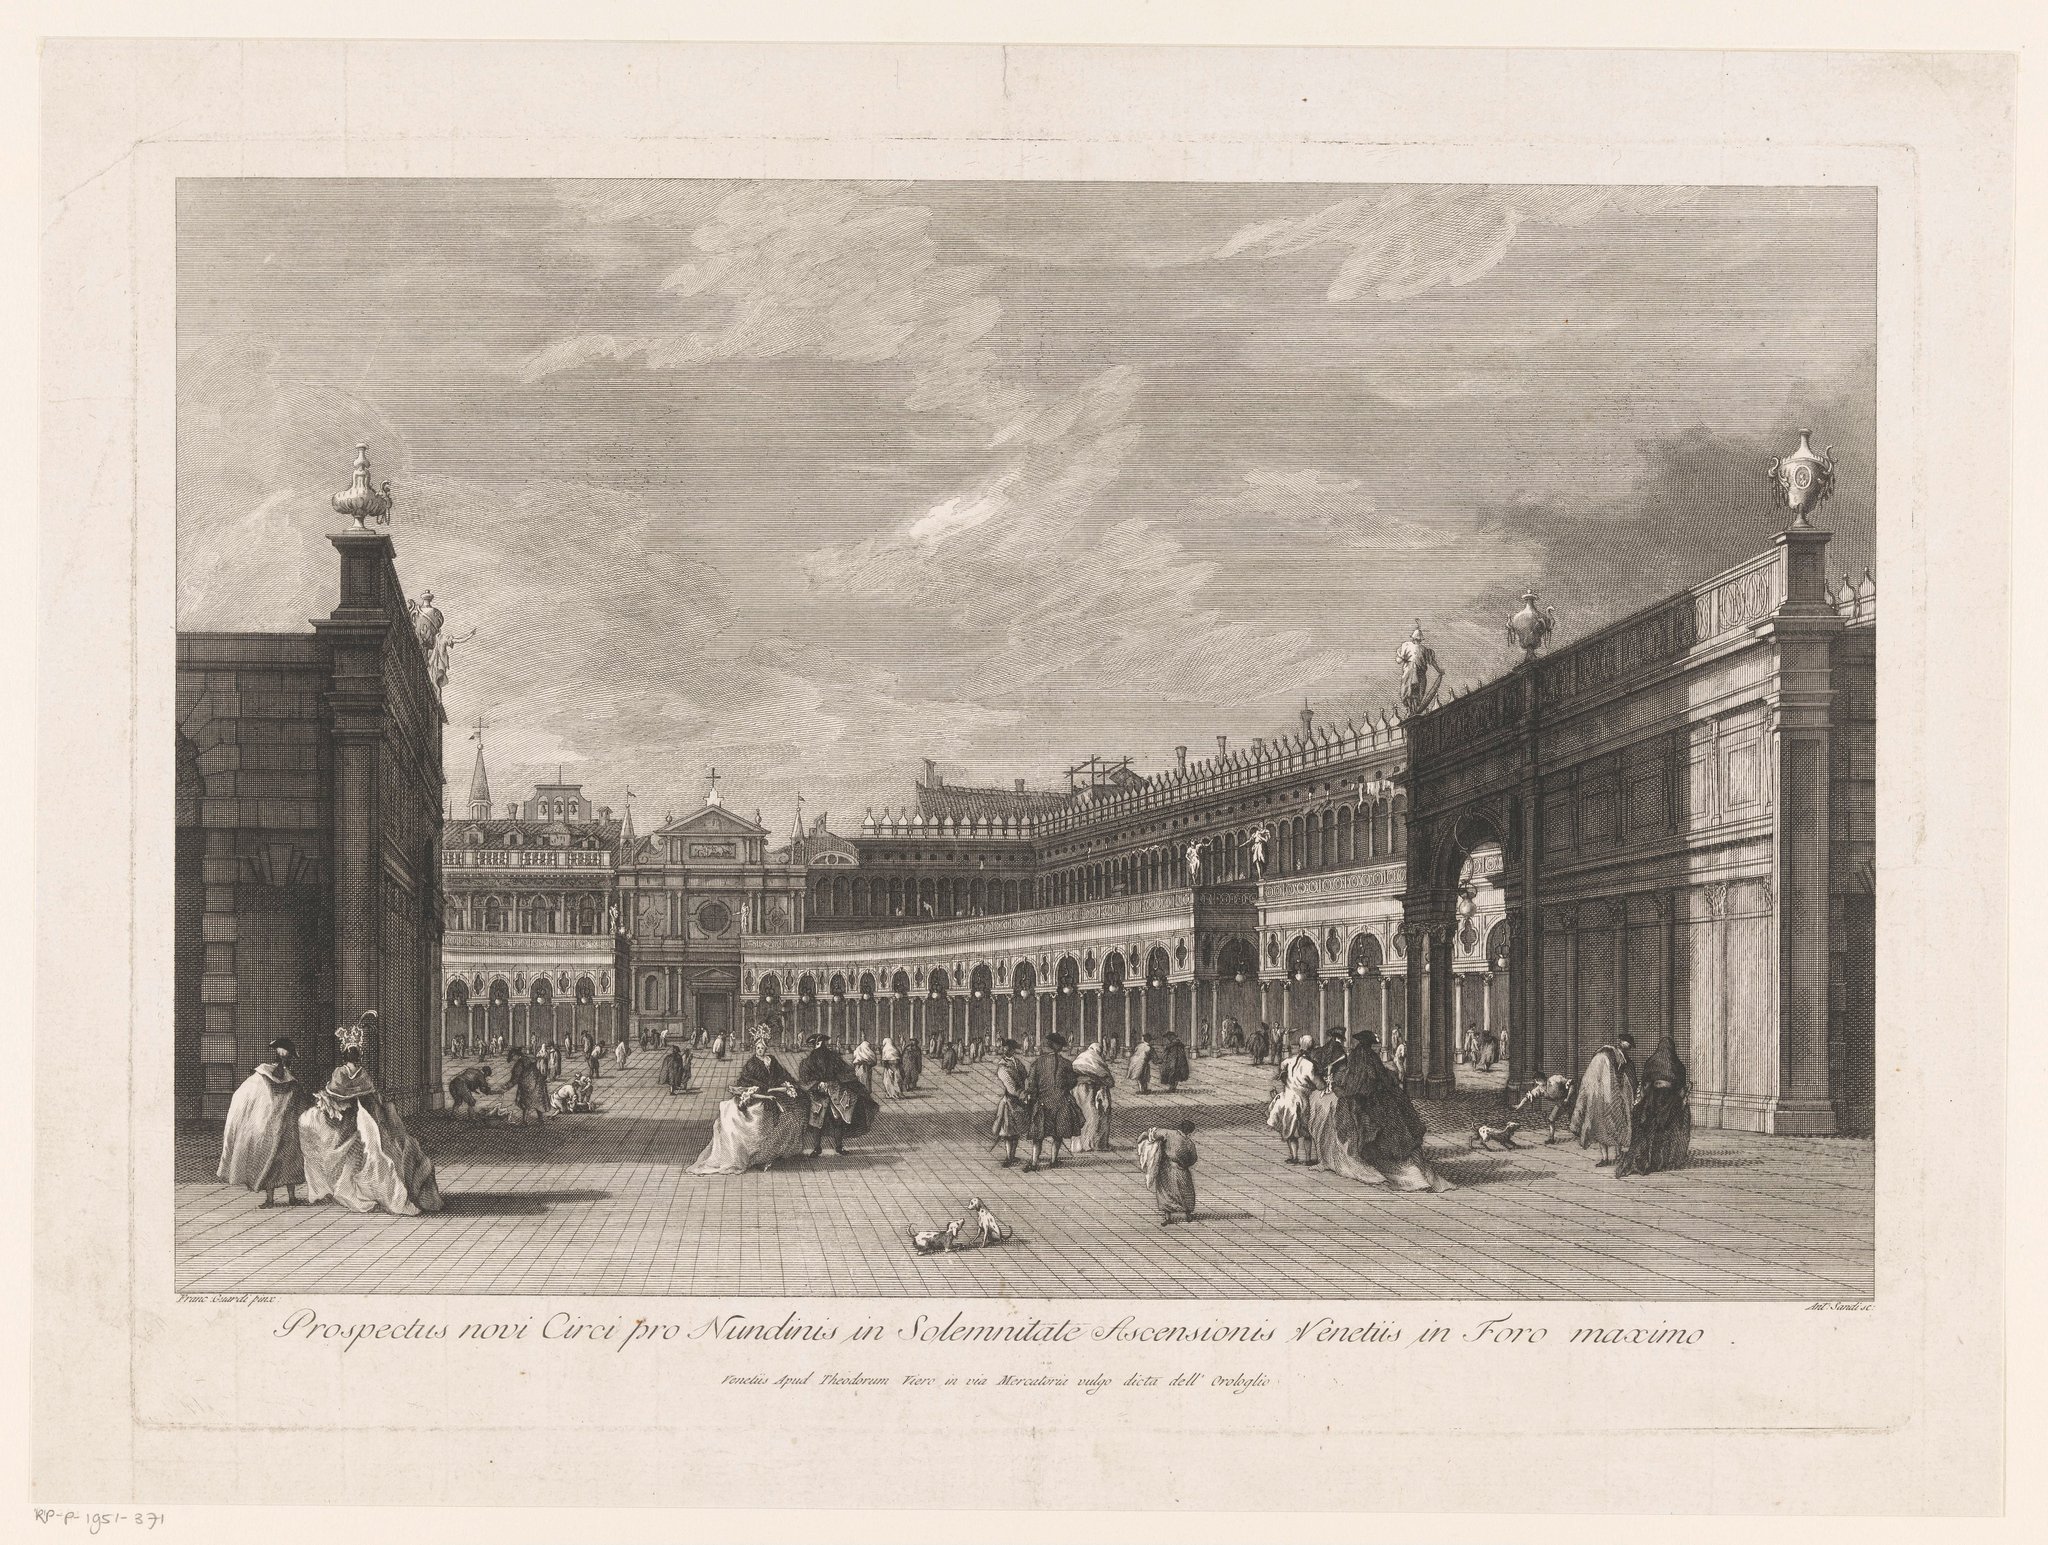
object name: print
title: Prospectus novi circi pro nundinis in solemnitate ascensionis Venetiis in foro maximo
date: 1743-1817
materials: paper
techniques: engraving, etching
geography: venice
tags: city-view, and landscape with man-made constructions, church (exterior), loggia, verandah, porch, venice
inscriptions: collector's mark: Lugt 2228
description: Deze prent maakt deel uit van een serie genummerde prenten met gezichten op Venetië.